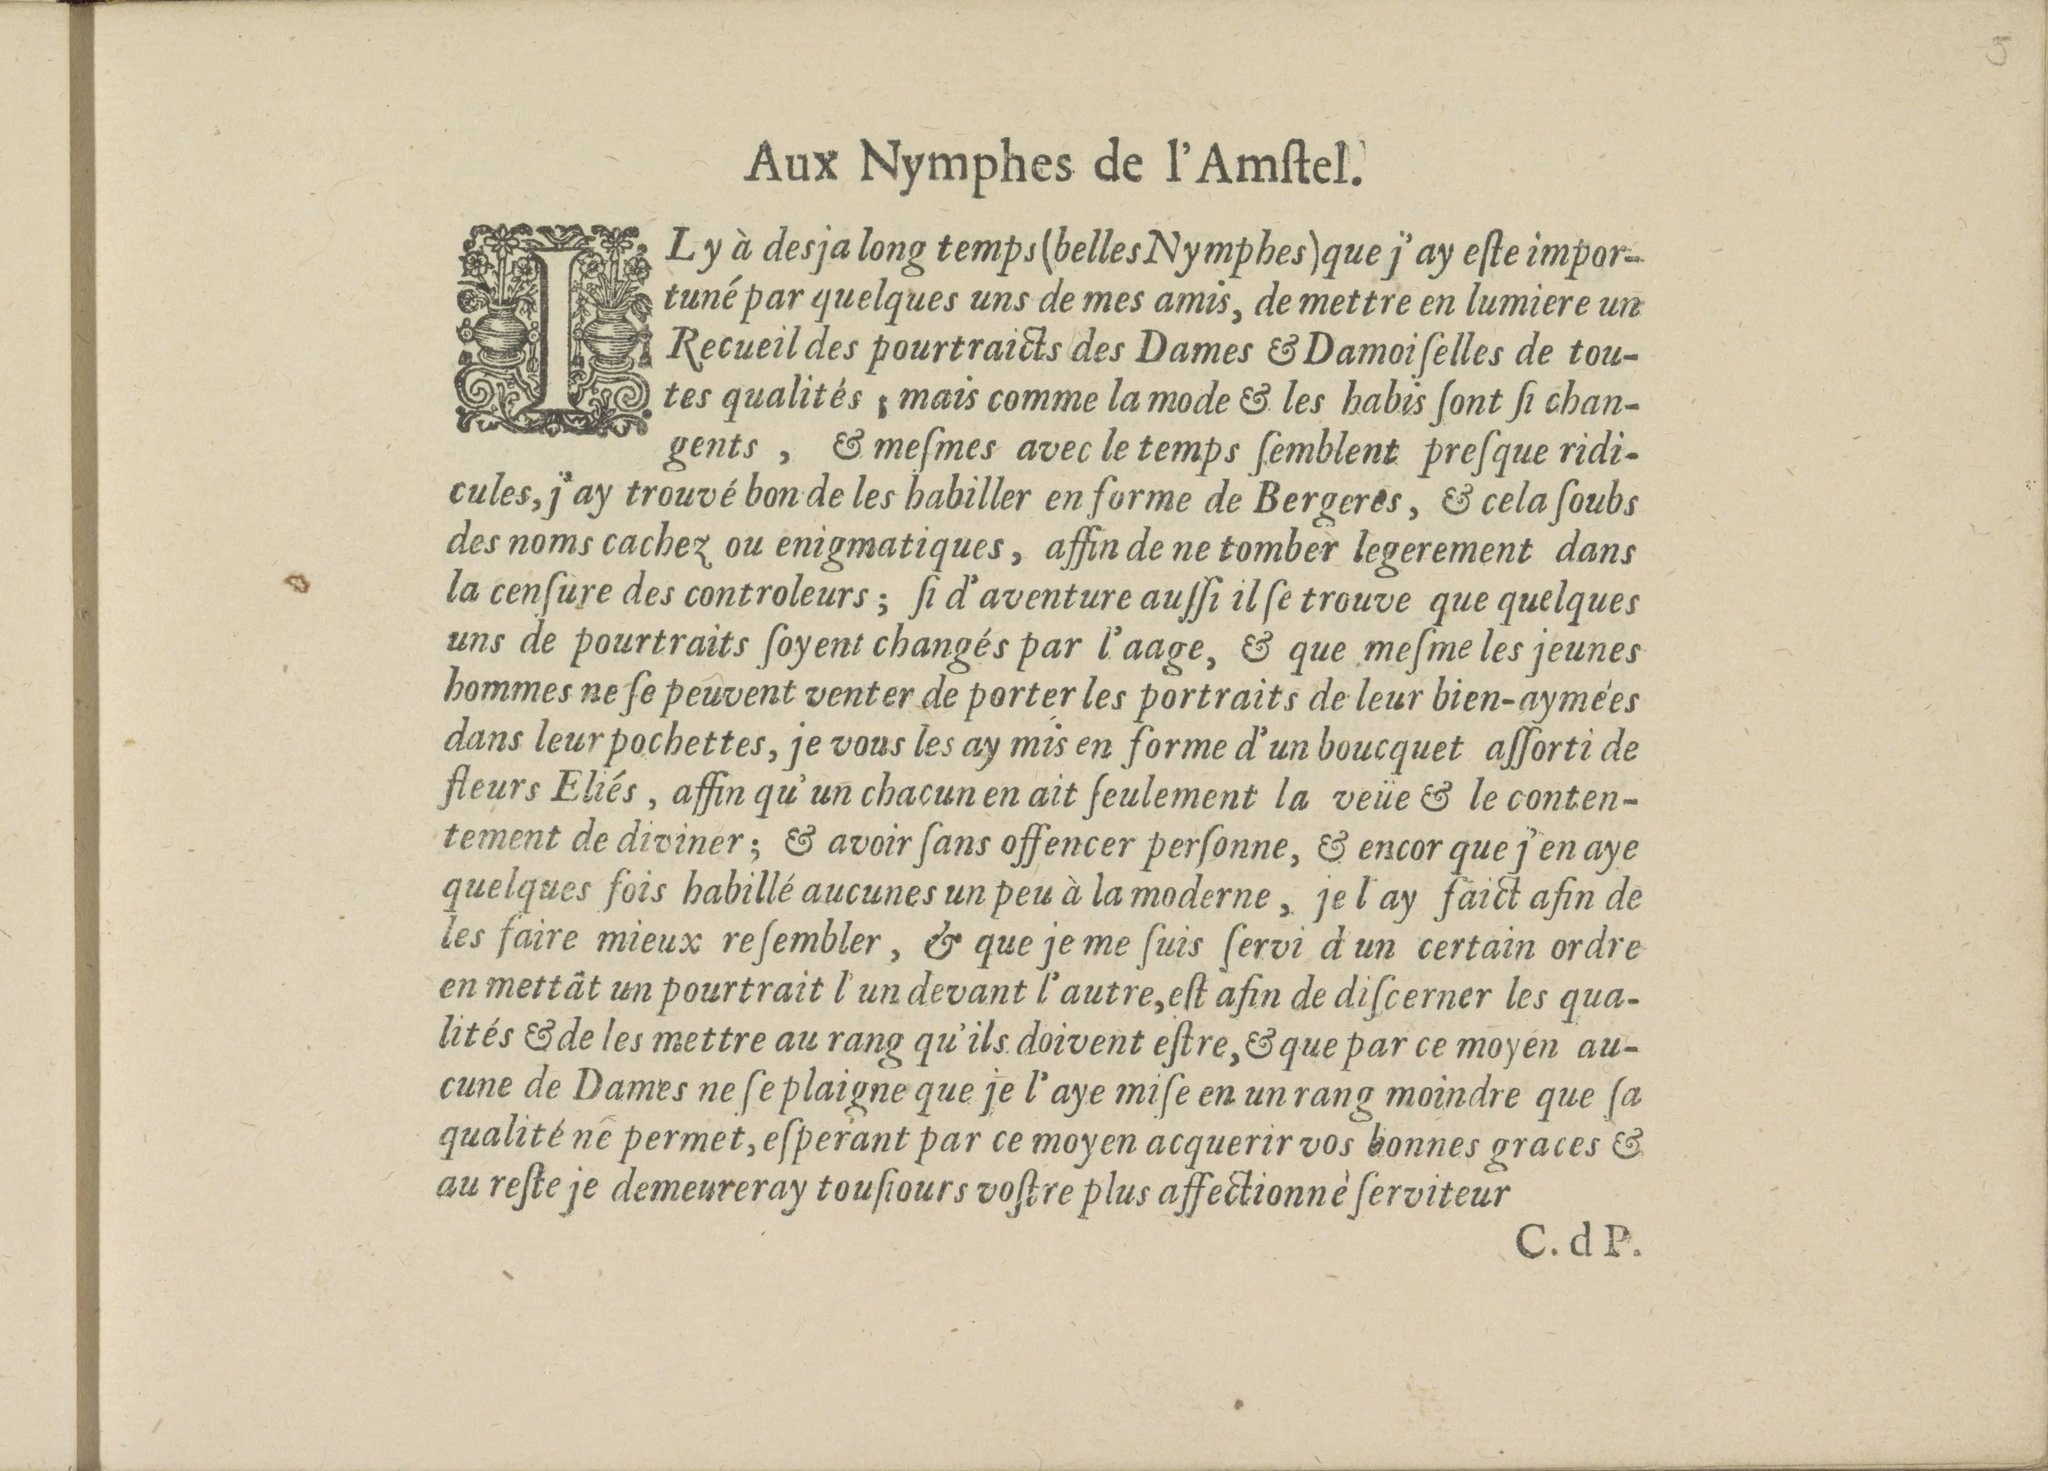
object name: album leaf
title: Les vrais pourtraits de quelques unes des plus grandes dames de la chrestiente desguisees en bergeres.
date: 1640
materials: paper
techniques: letterpress printing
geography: amsterdam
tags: initial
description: Franstalig voorwoord met de aanhef: Aux nymphes de l'Amstel. De tekst vangt aan met een gedecoreerde initiaal I en is ondertekend: C.dP. Het blad maakt deel uit van een album.